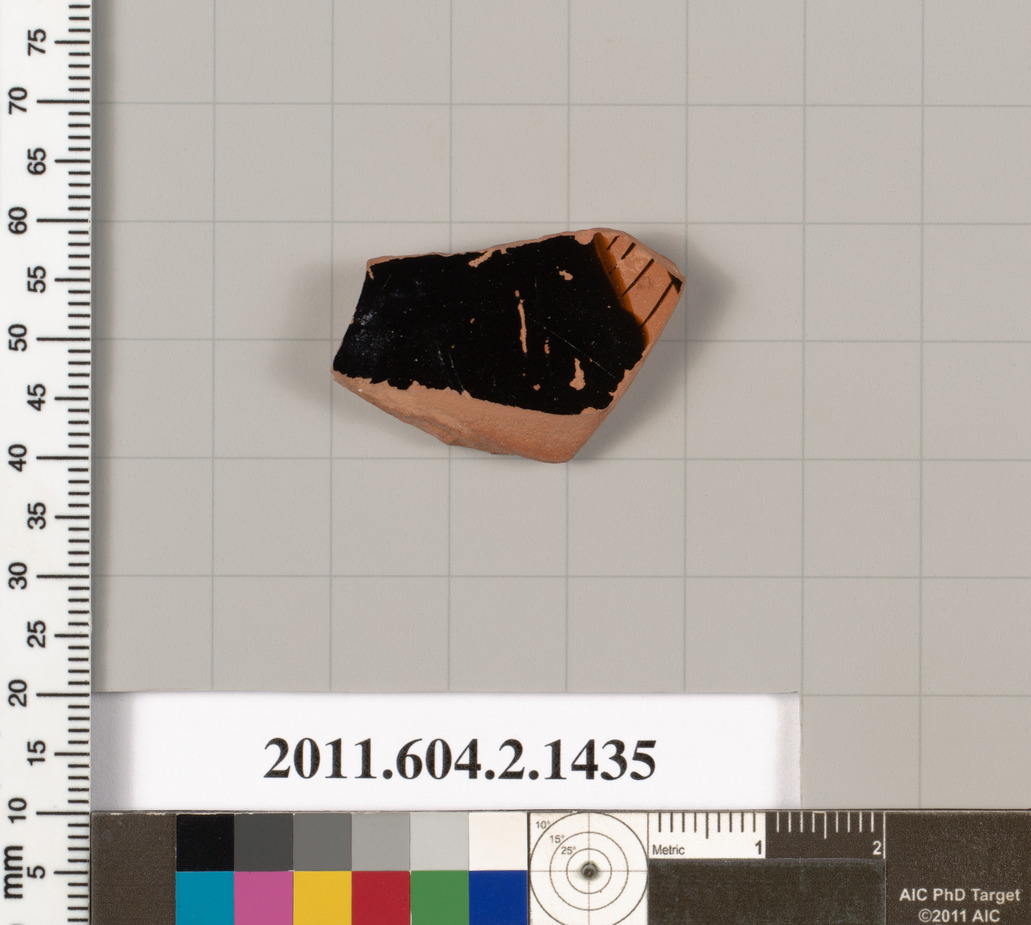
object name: skyphos fragment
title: Terracotta fragment of a skyphos (deep drinking cup)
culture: greek, attic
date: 450-426 BCE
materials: terracotta